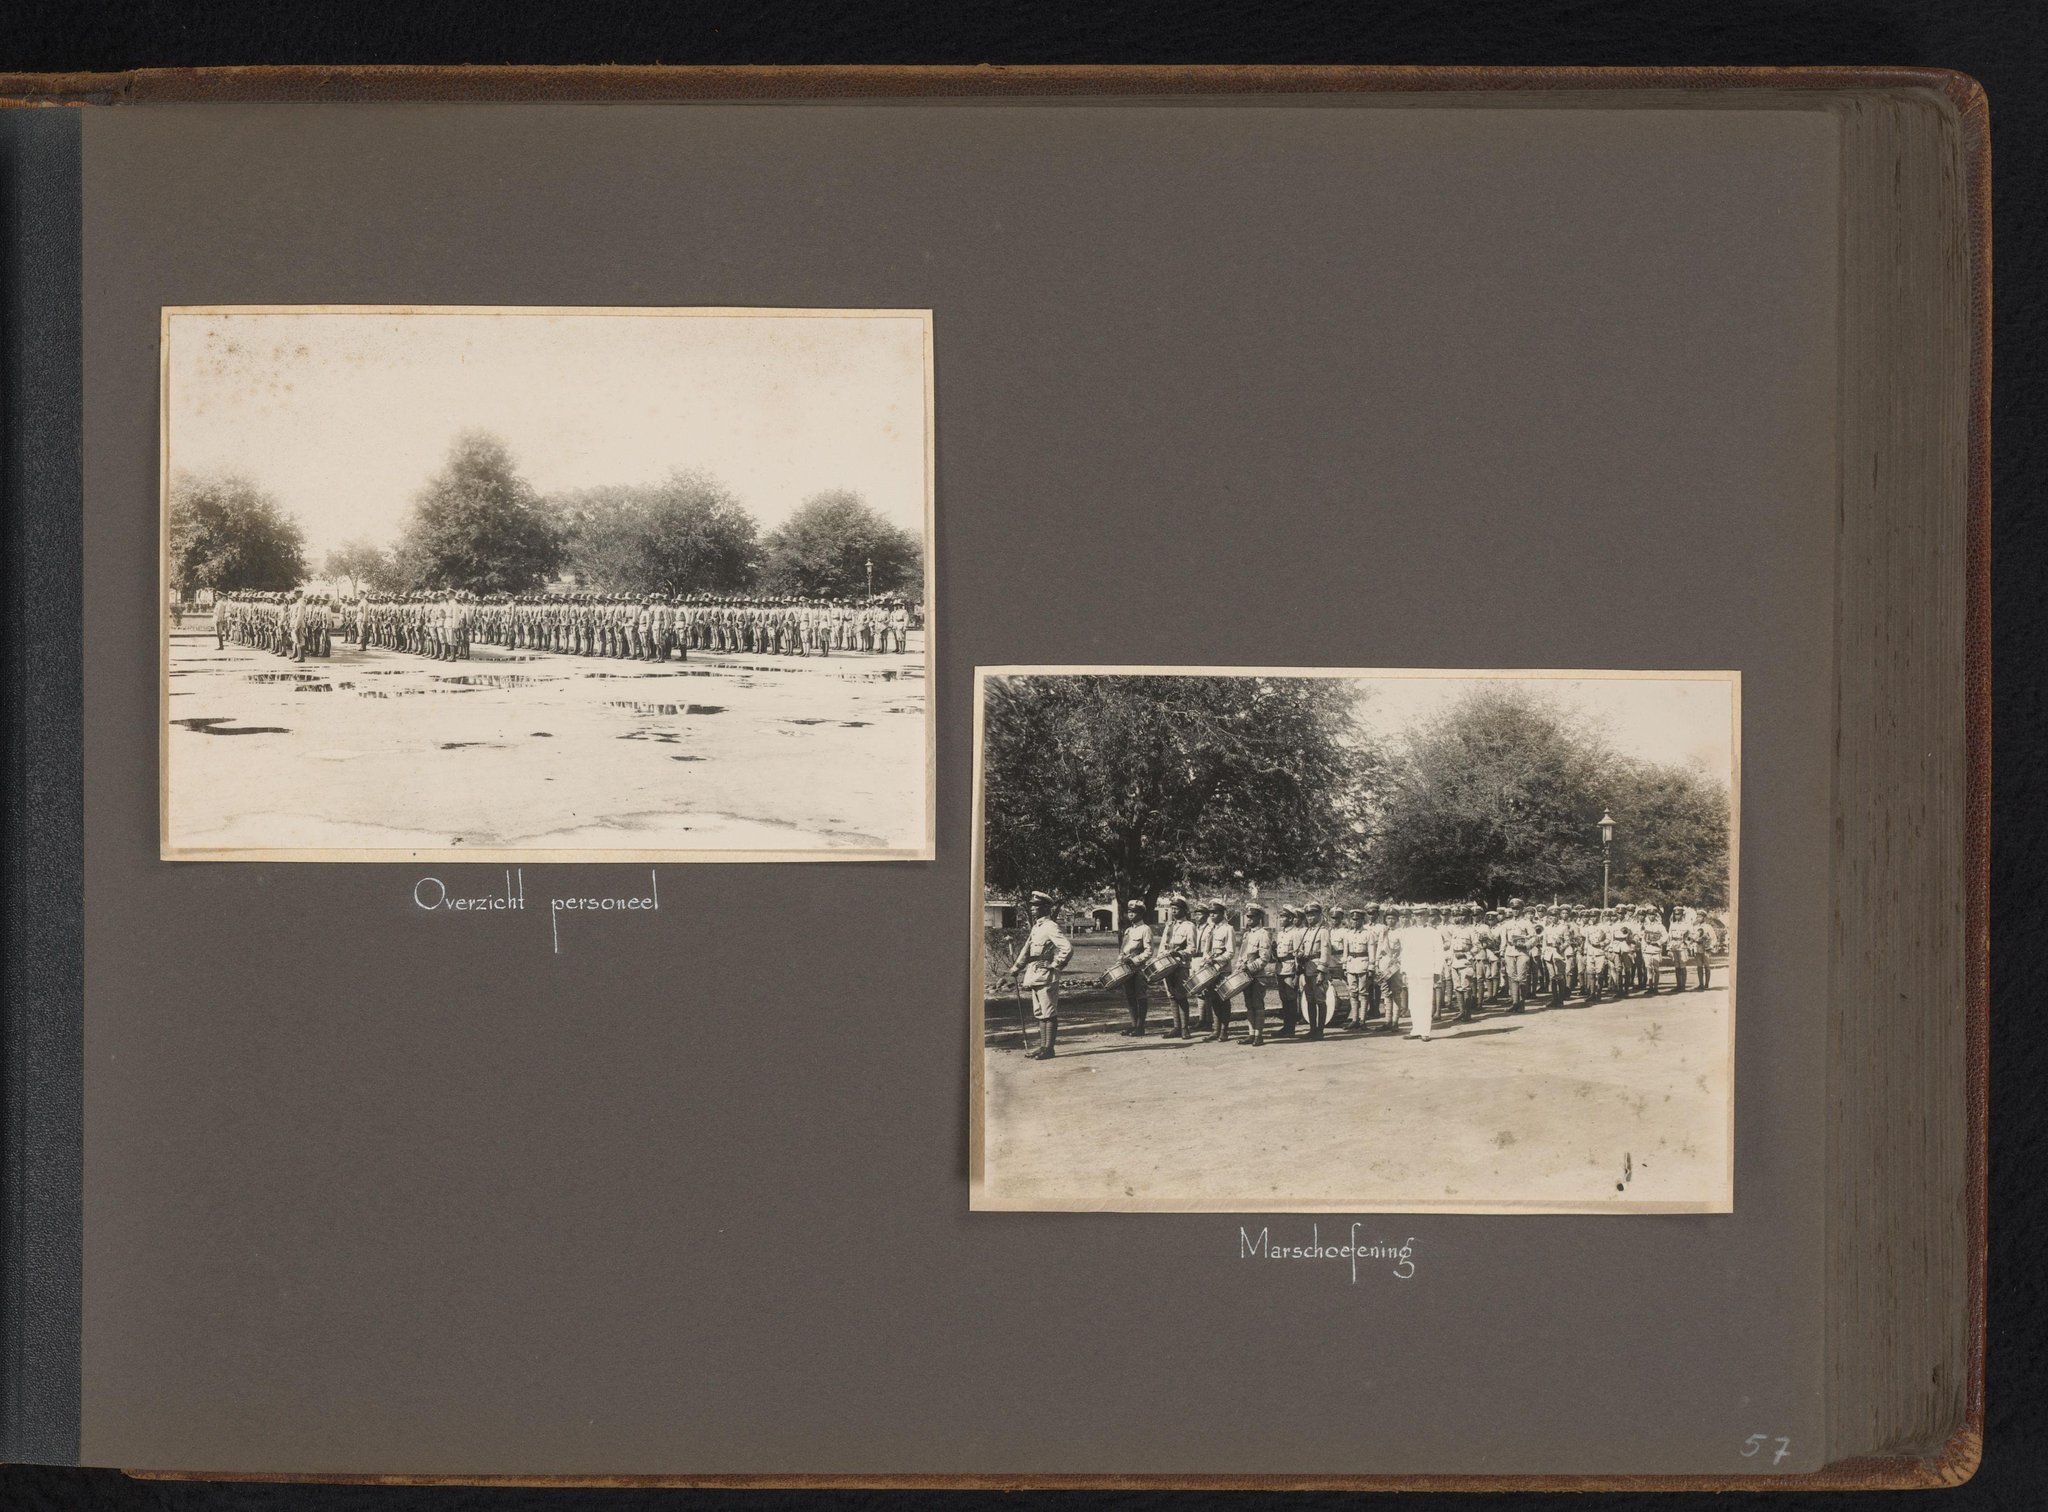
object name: photograph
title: Overzicht personeel / Marschoefening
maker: Anonymous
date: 1925-1931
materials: cardboard, photographic support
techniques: gelatin silver print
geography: semarang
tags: semarang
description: Albumblad met twee foto's: exercitie door het voltallige personeel van de politie te Semarang en het muziekkorps. Onderdeel van het fotoalbum aangeboden aan S. Koster door de Vereeniging van Hoogere Politie Ambtenaren in Nederlandsch-Indië in 1931.